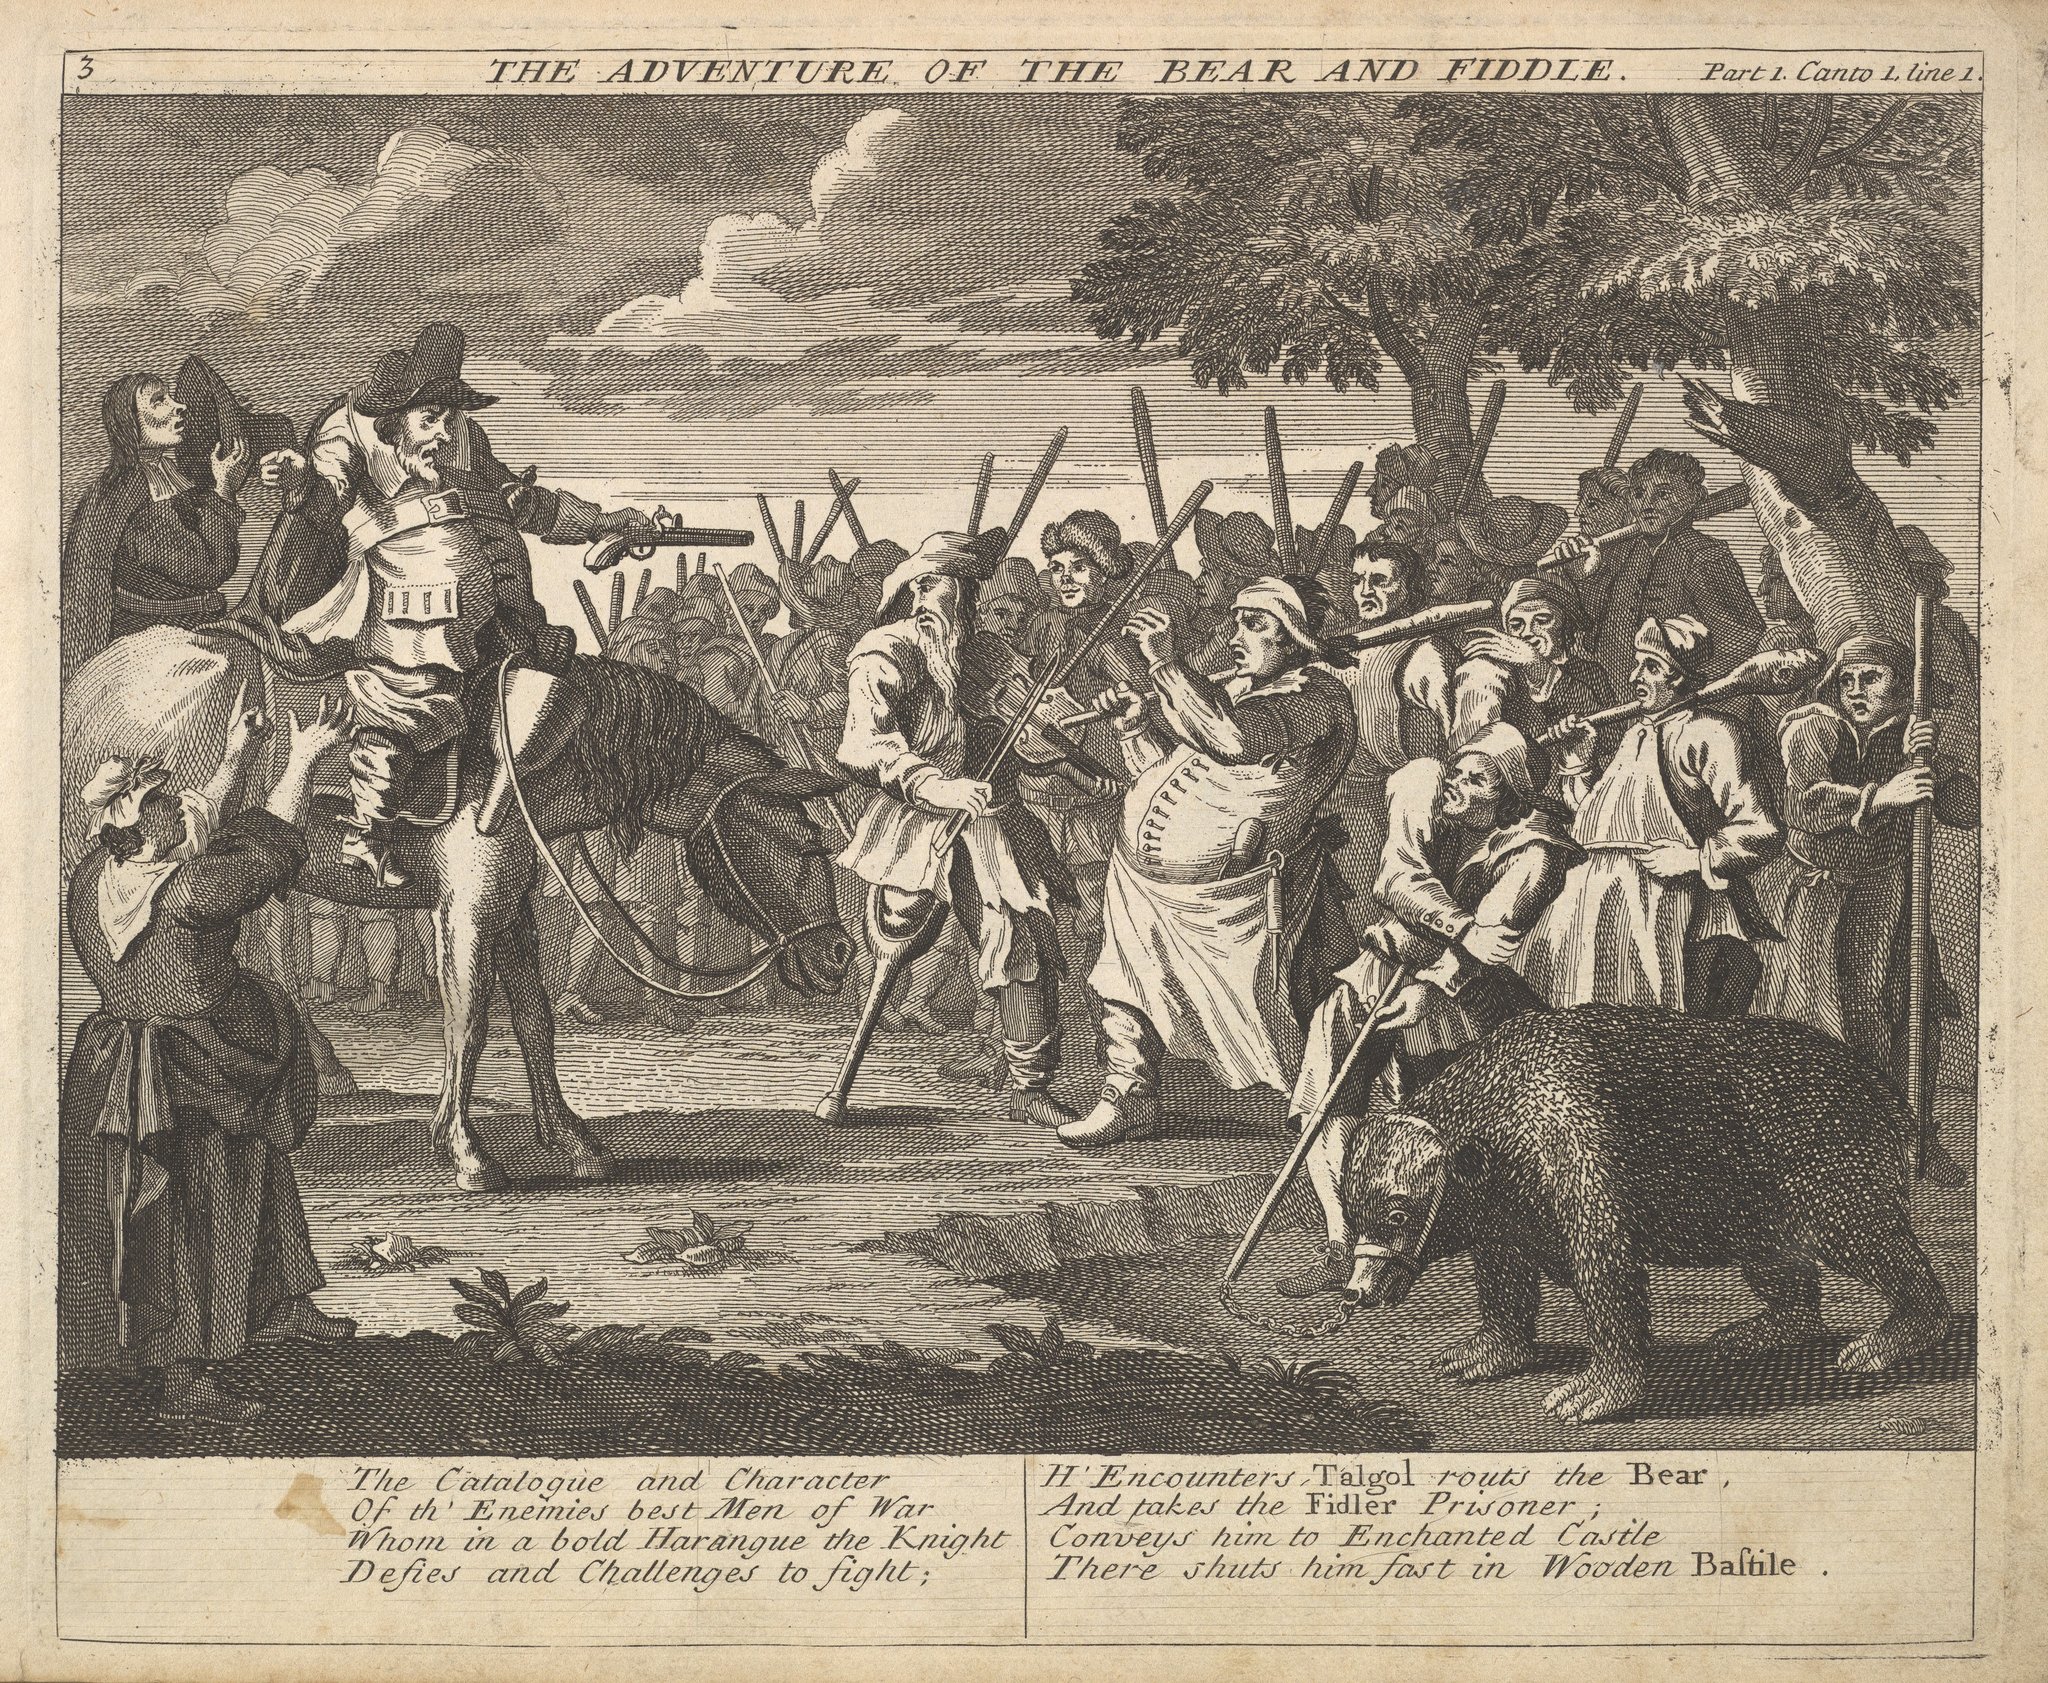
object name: print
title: The Adventure of the Bear and the Fiddle (Plate 3: Illustrations to Samuel Butler's Hudibras)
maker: william hogarth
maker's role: artist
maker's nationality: british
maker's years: 1697-1764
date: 1725-1730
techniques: engraving, etching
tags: bears,weapons,men,horses